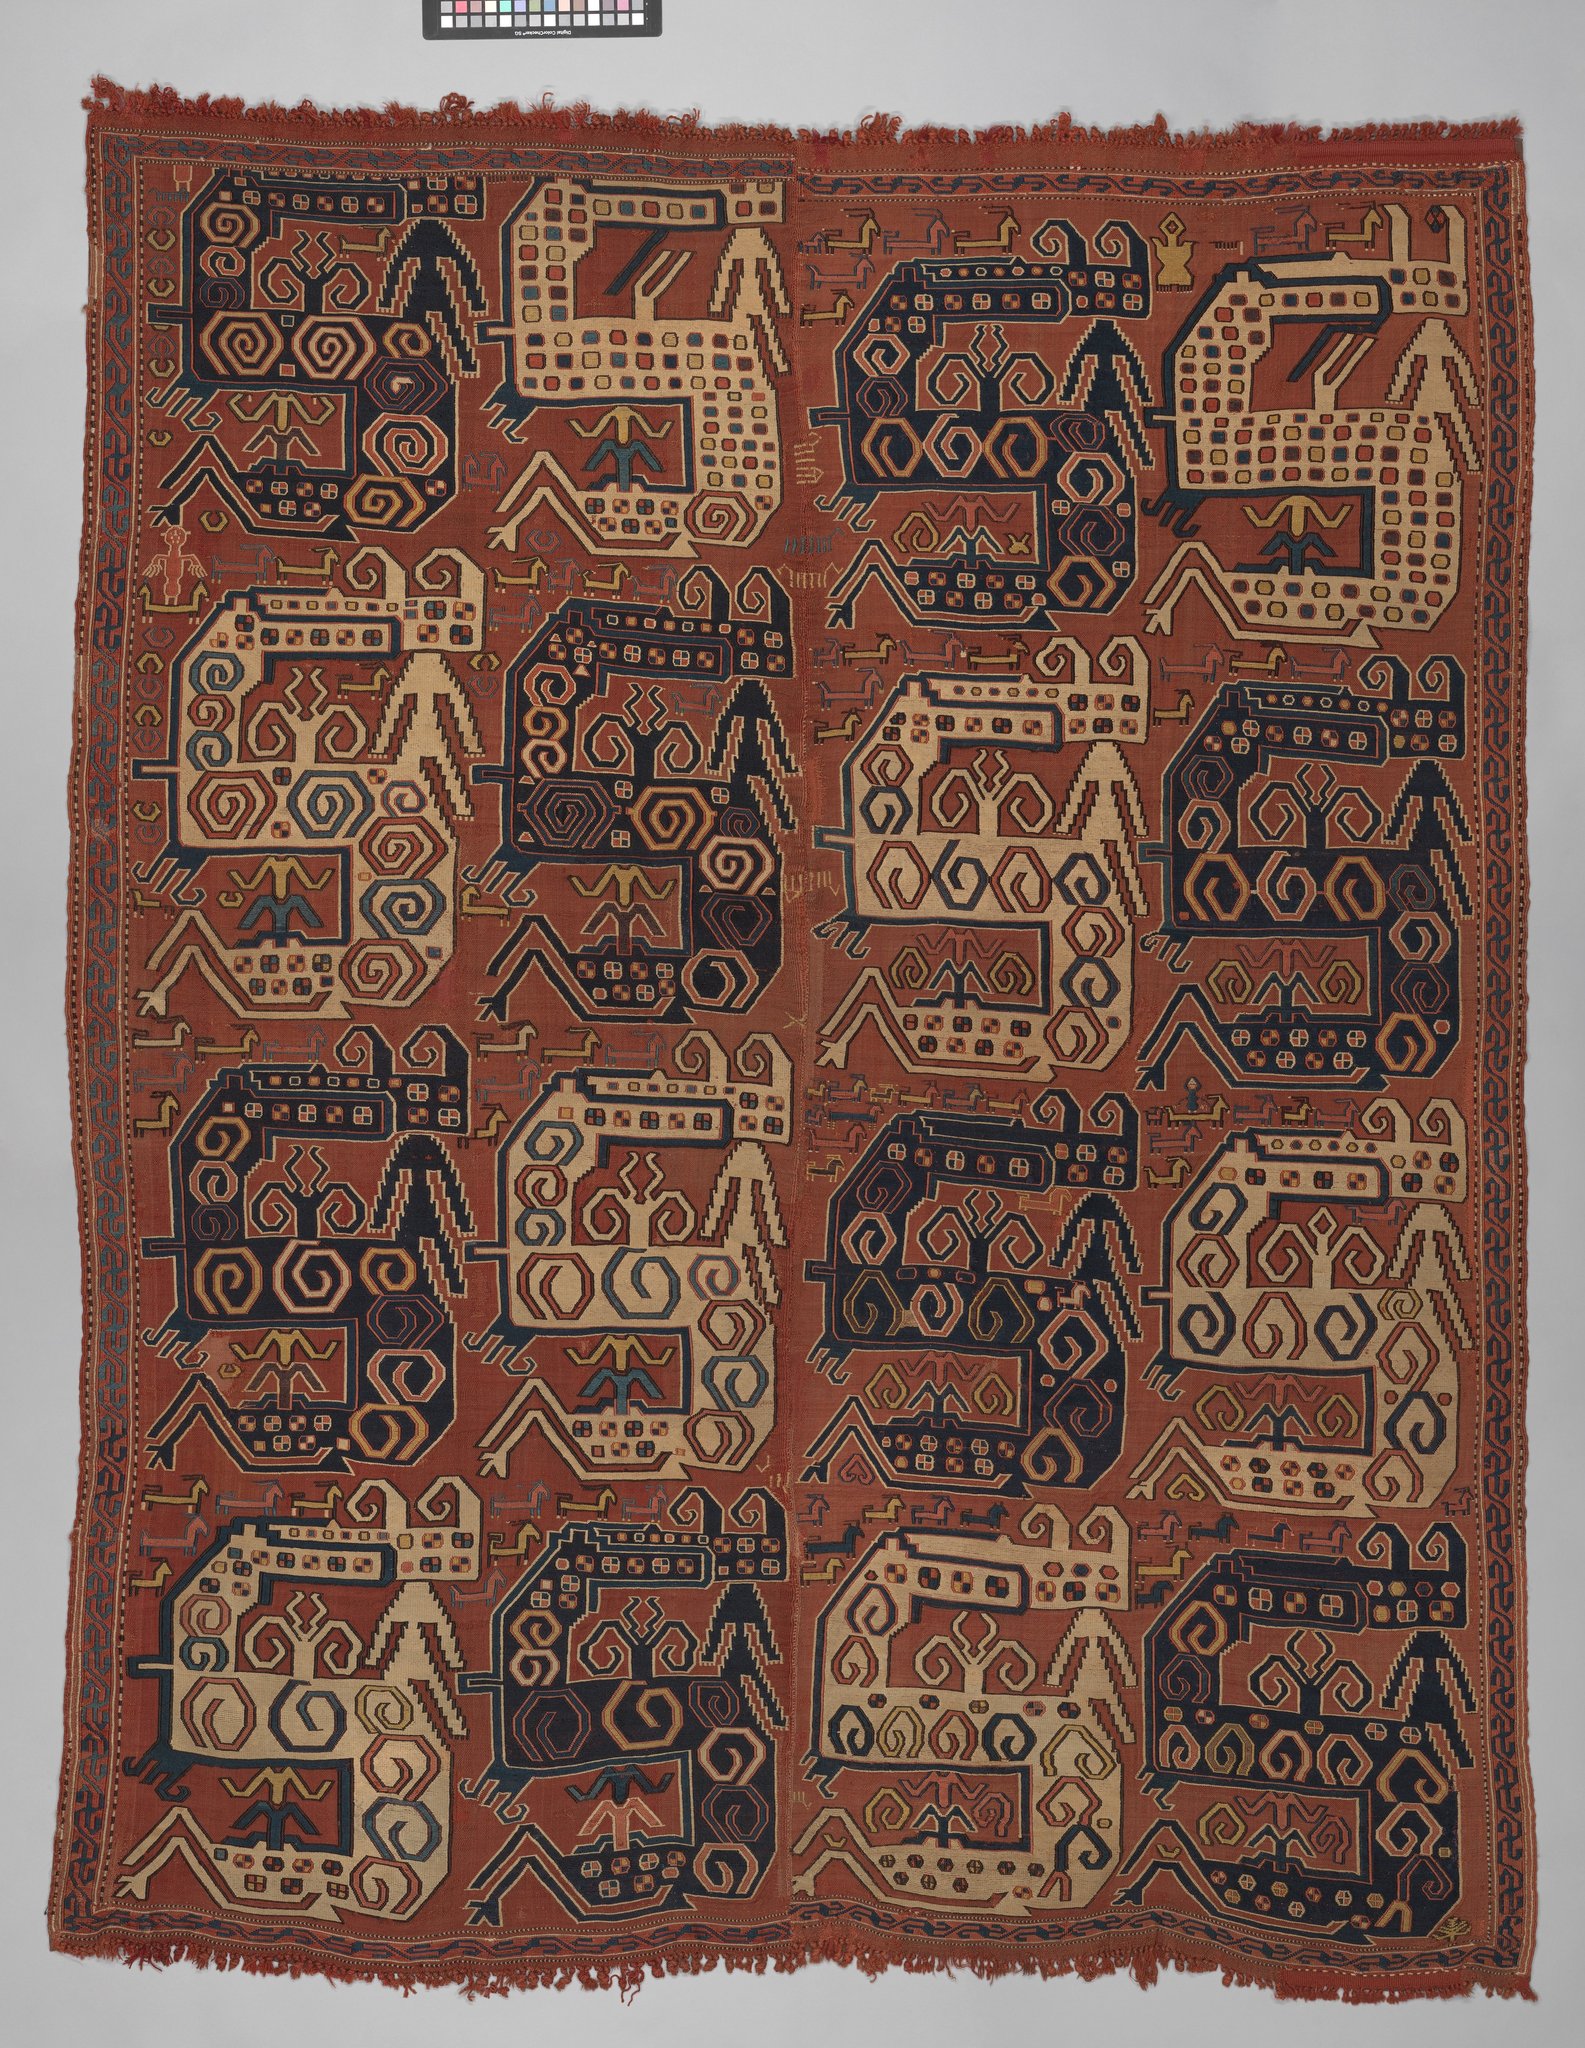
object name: carpet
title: Dragon Carpet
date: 1767-1833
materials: cotton, wool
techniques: embroidery, weave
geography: azerbaijan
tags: dragons